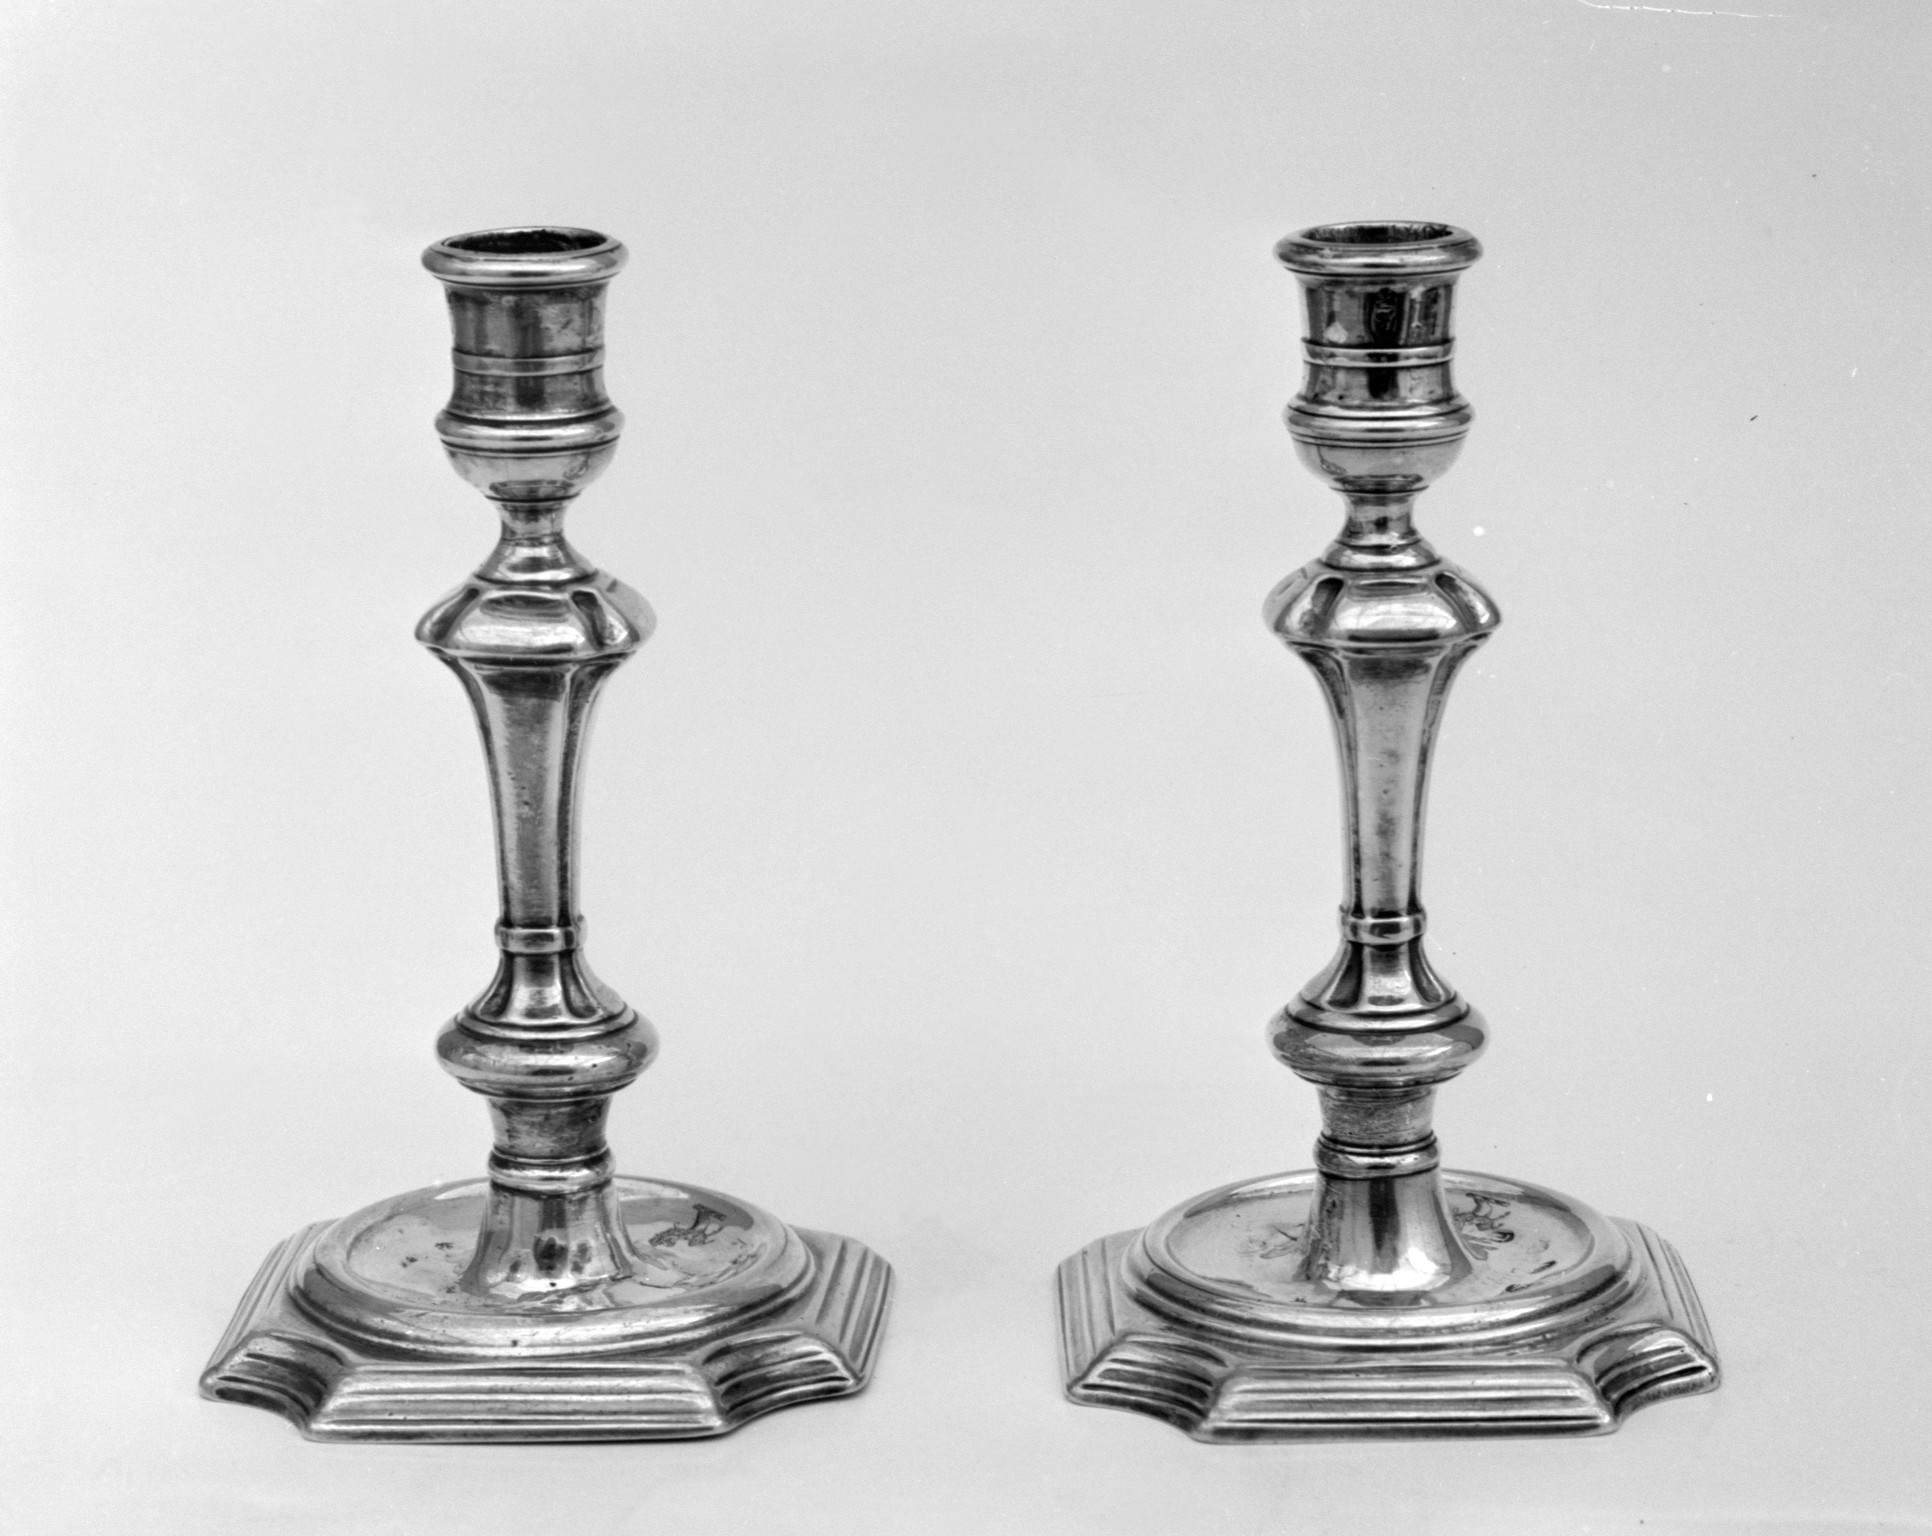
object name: candlestick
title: Pair of candlesticks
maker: robert calderwood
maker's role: maker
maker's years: 1665-1765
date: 1730-1732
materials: silver